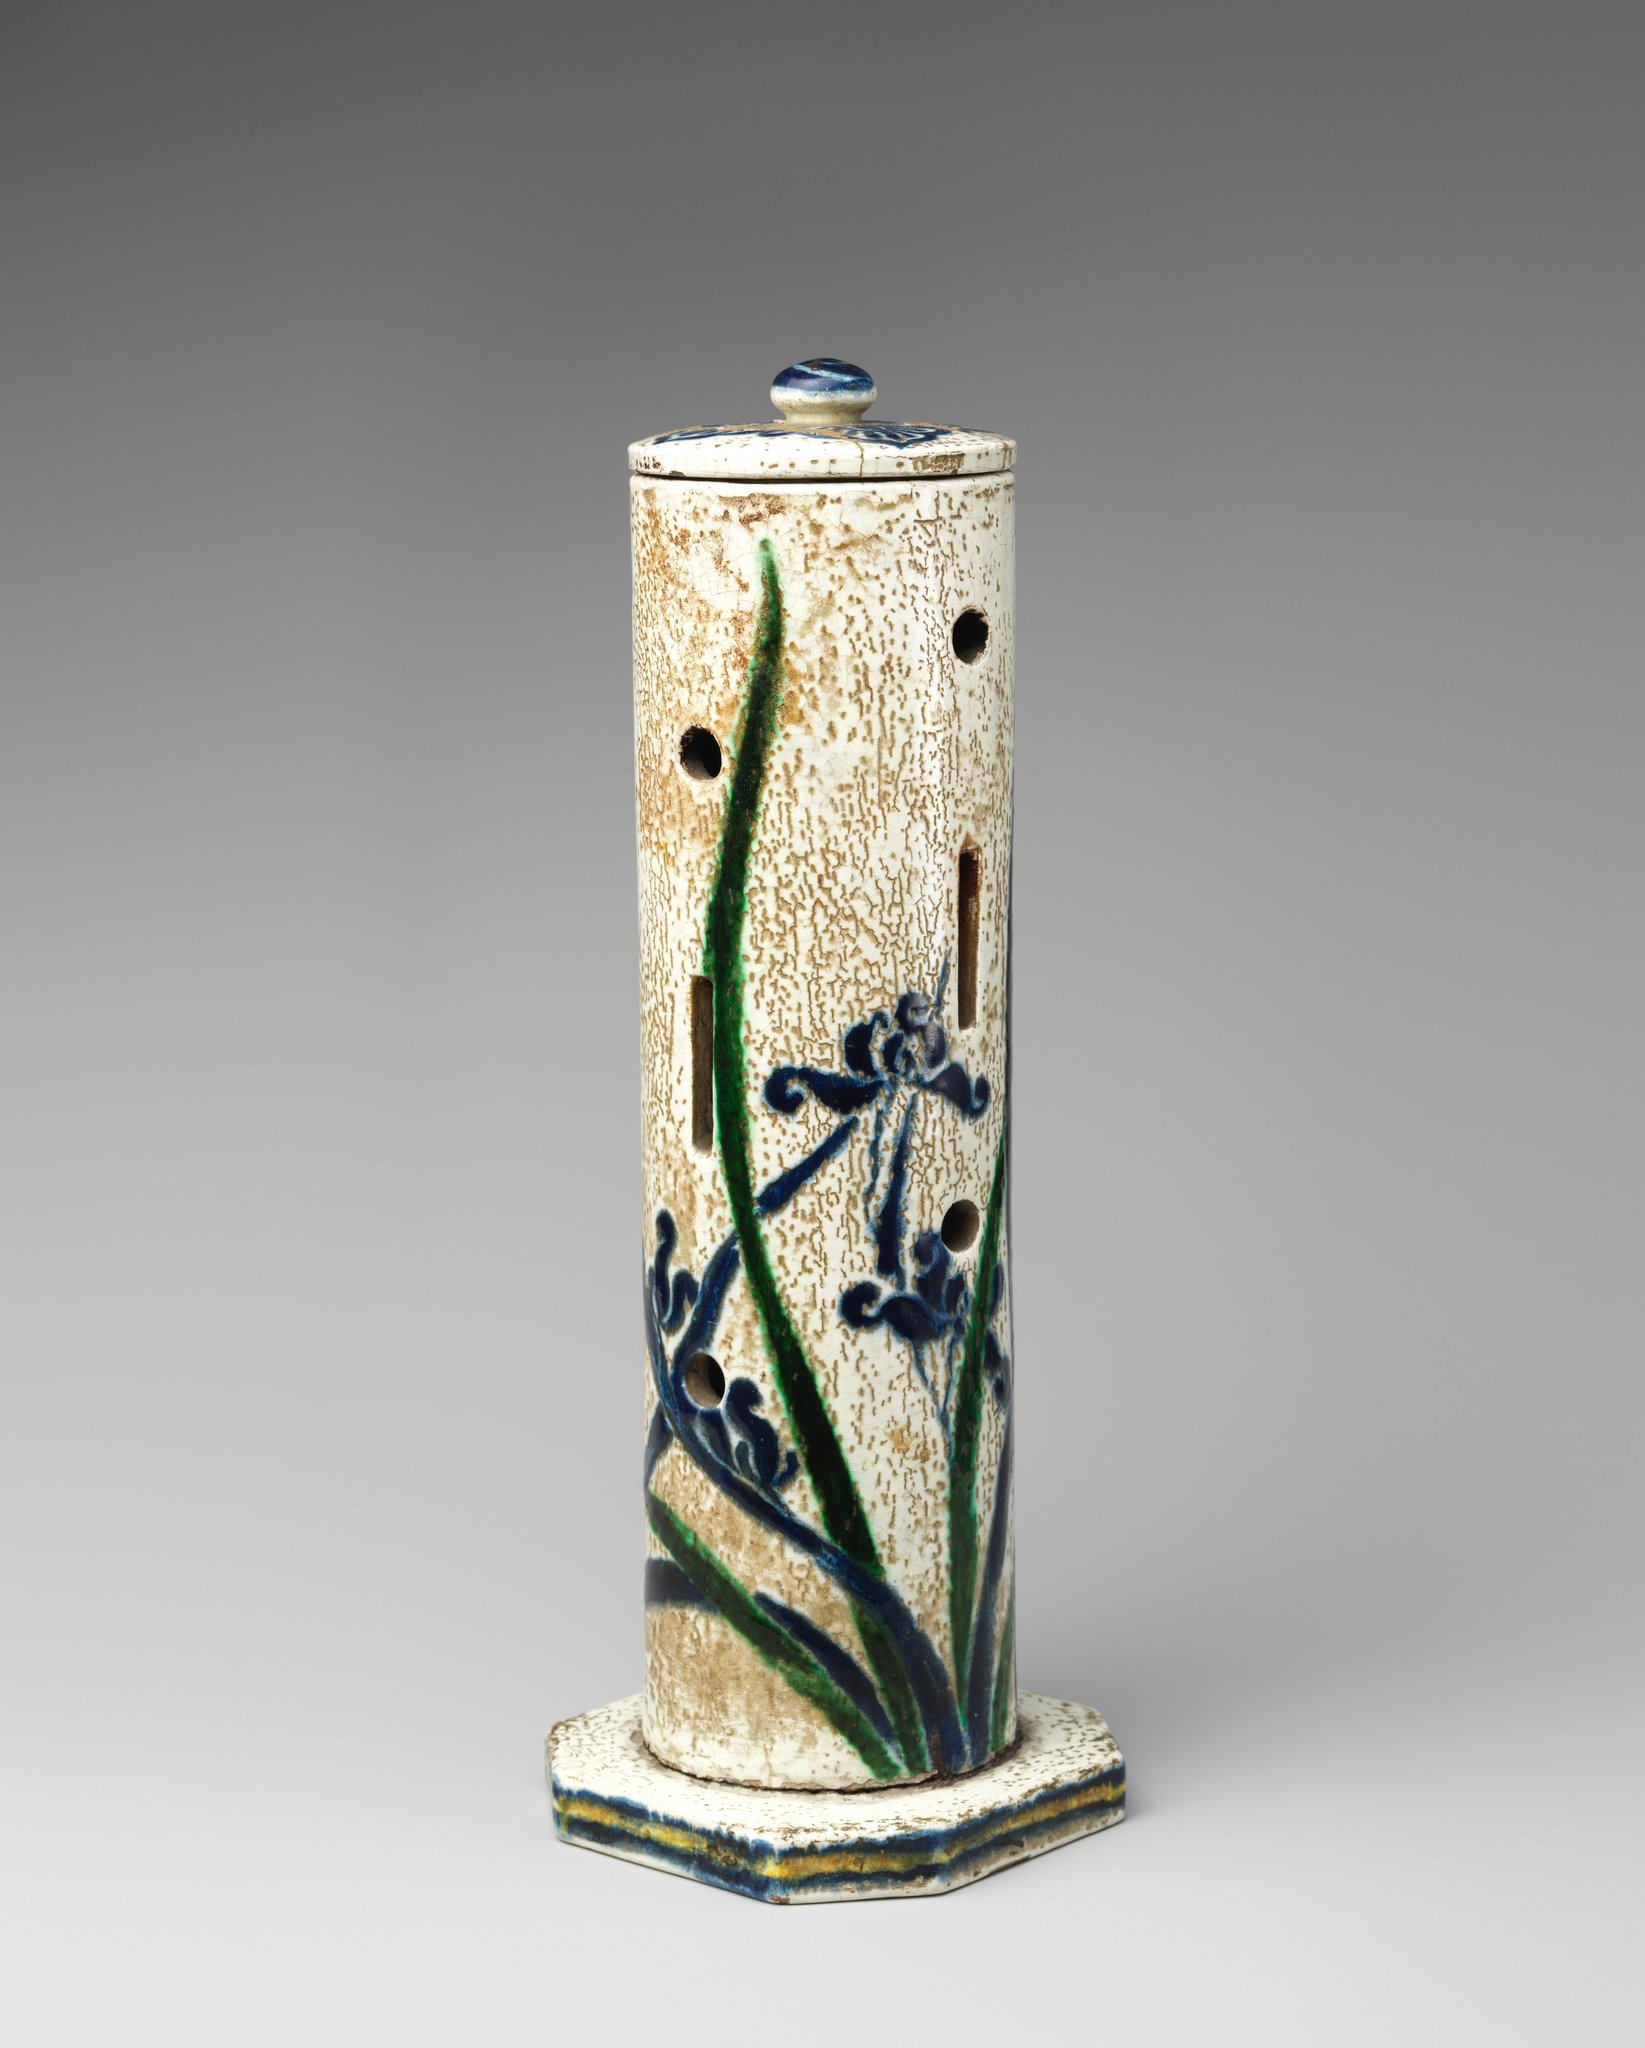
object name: mosquito smoker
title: Mosquito Smoker (Katori)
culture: japanese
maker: minzan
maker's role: artist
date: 1801-1850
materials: earthenware, enamel, glaze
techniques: overglaze, polychrome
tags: flowers